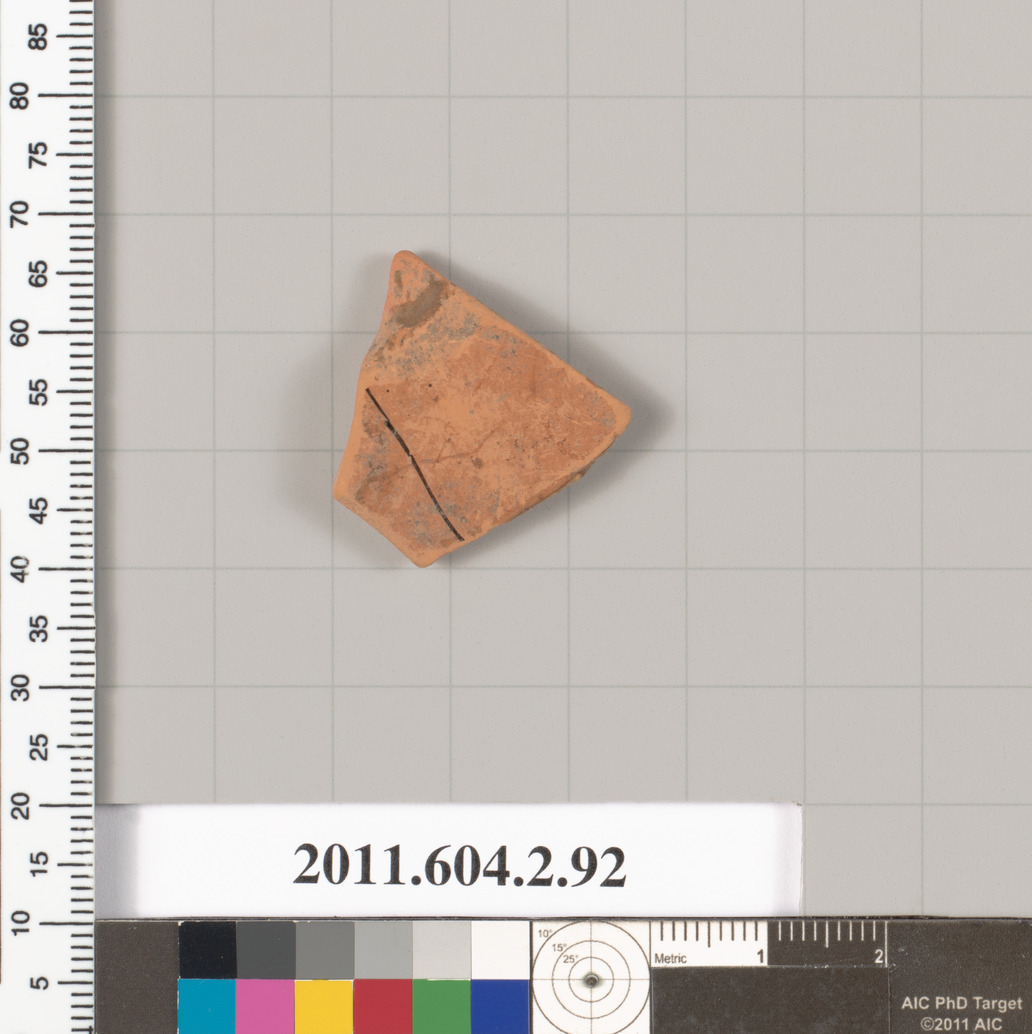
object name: pelike fragment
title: Terracotta fragment of a pelike (jar)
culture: greek, attic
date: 490-470 BCE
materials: terracotta